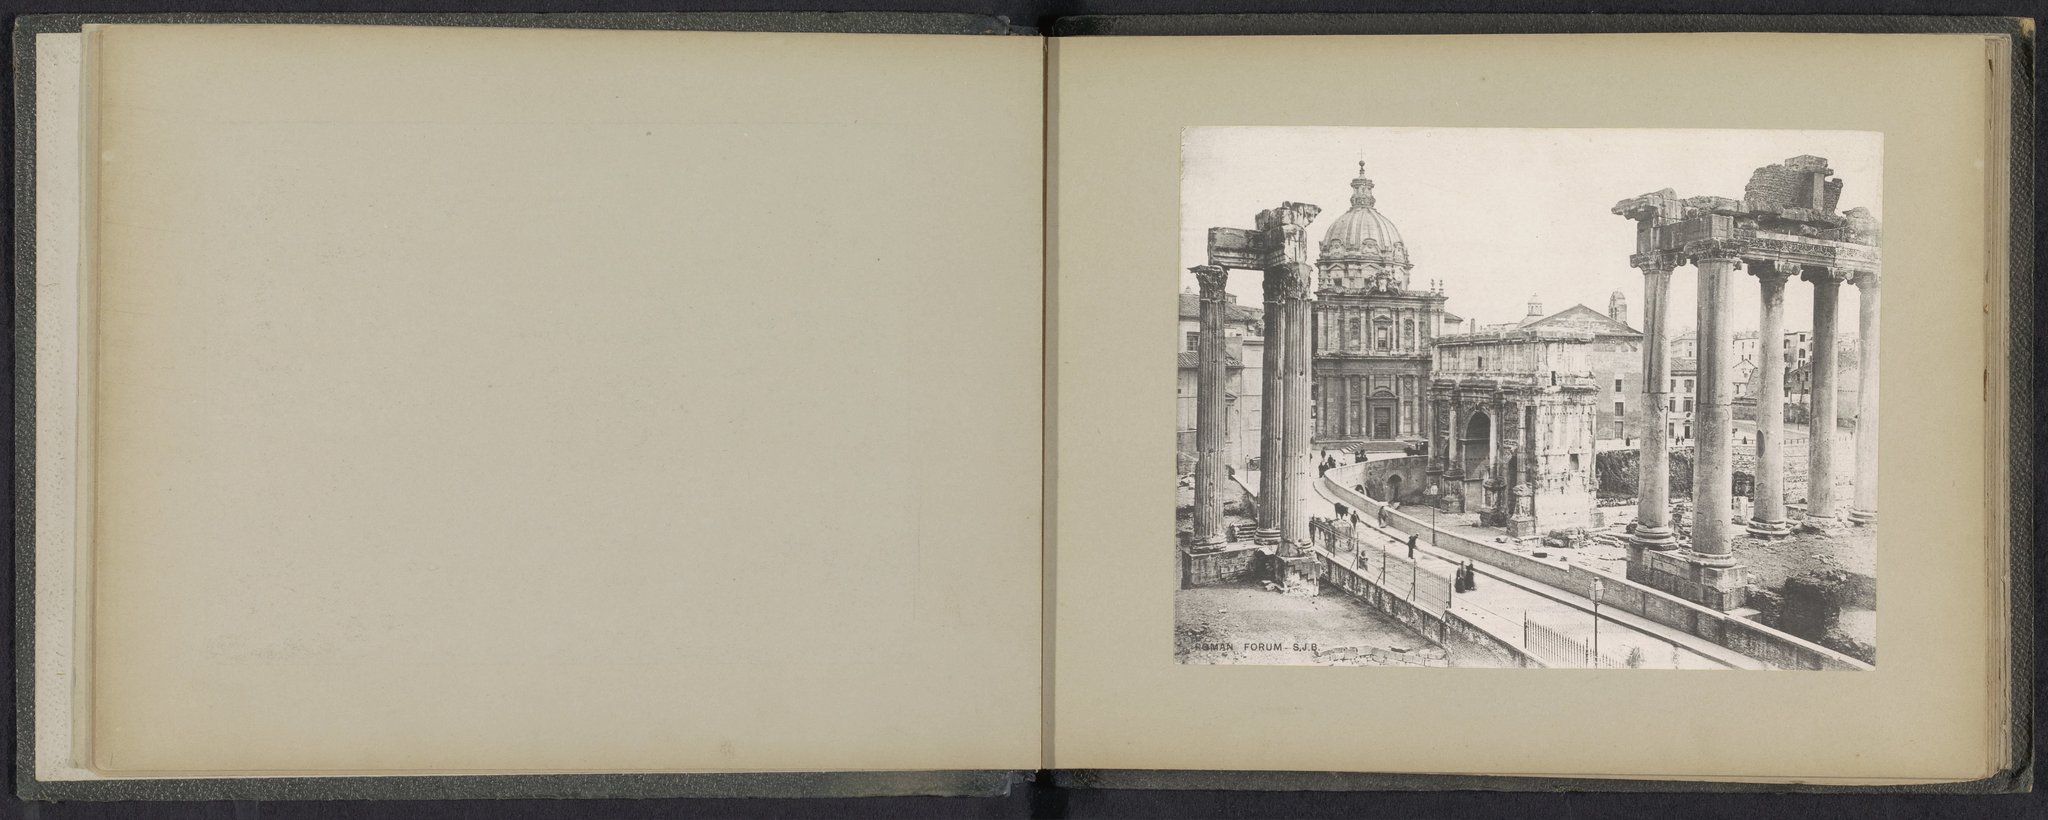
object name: photomechanical print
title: Roman Forum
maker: samuel j. beckett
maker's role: fotograaf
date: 1890-1900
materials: paper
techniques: photograph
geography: forum romanum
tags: landscape with ruins, façade (of house or building)